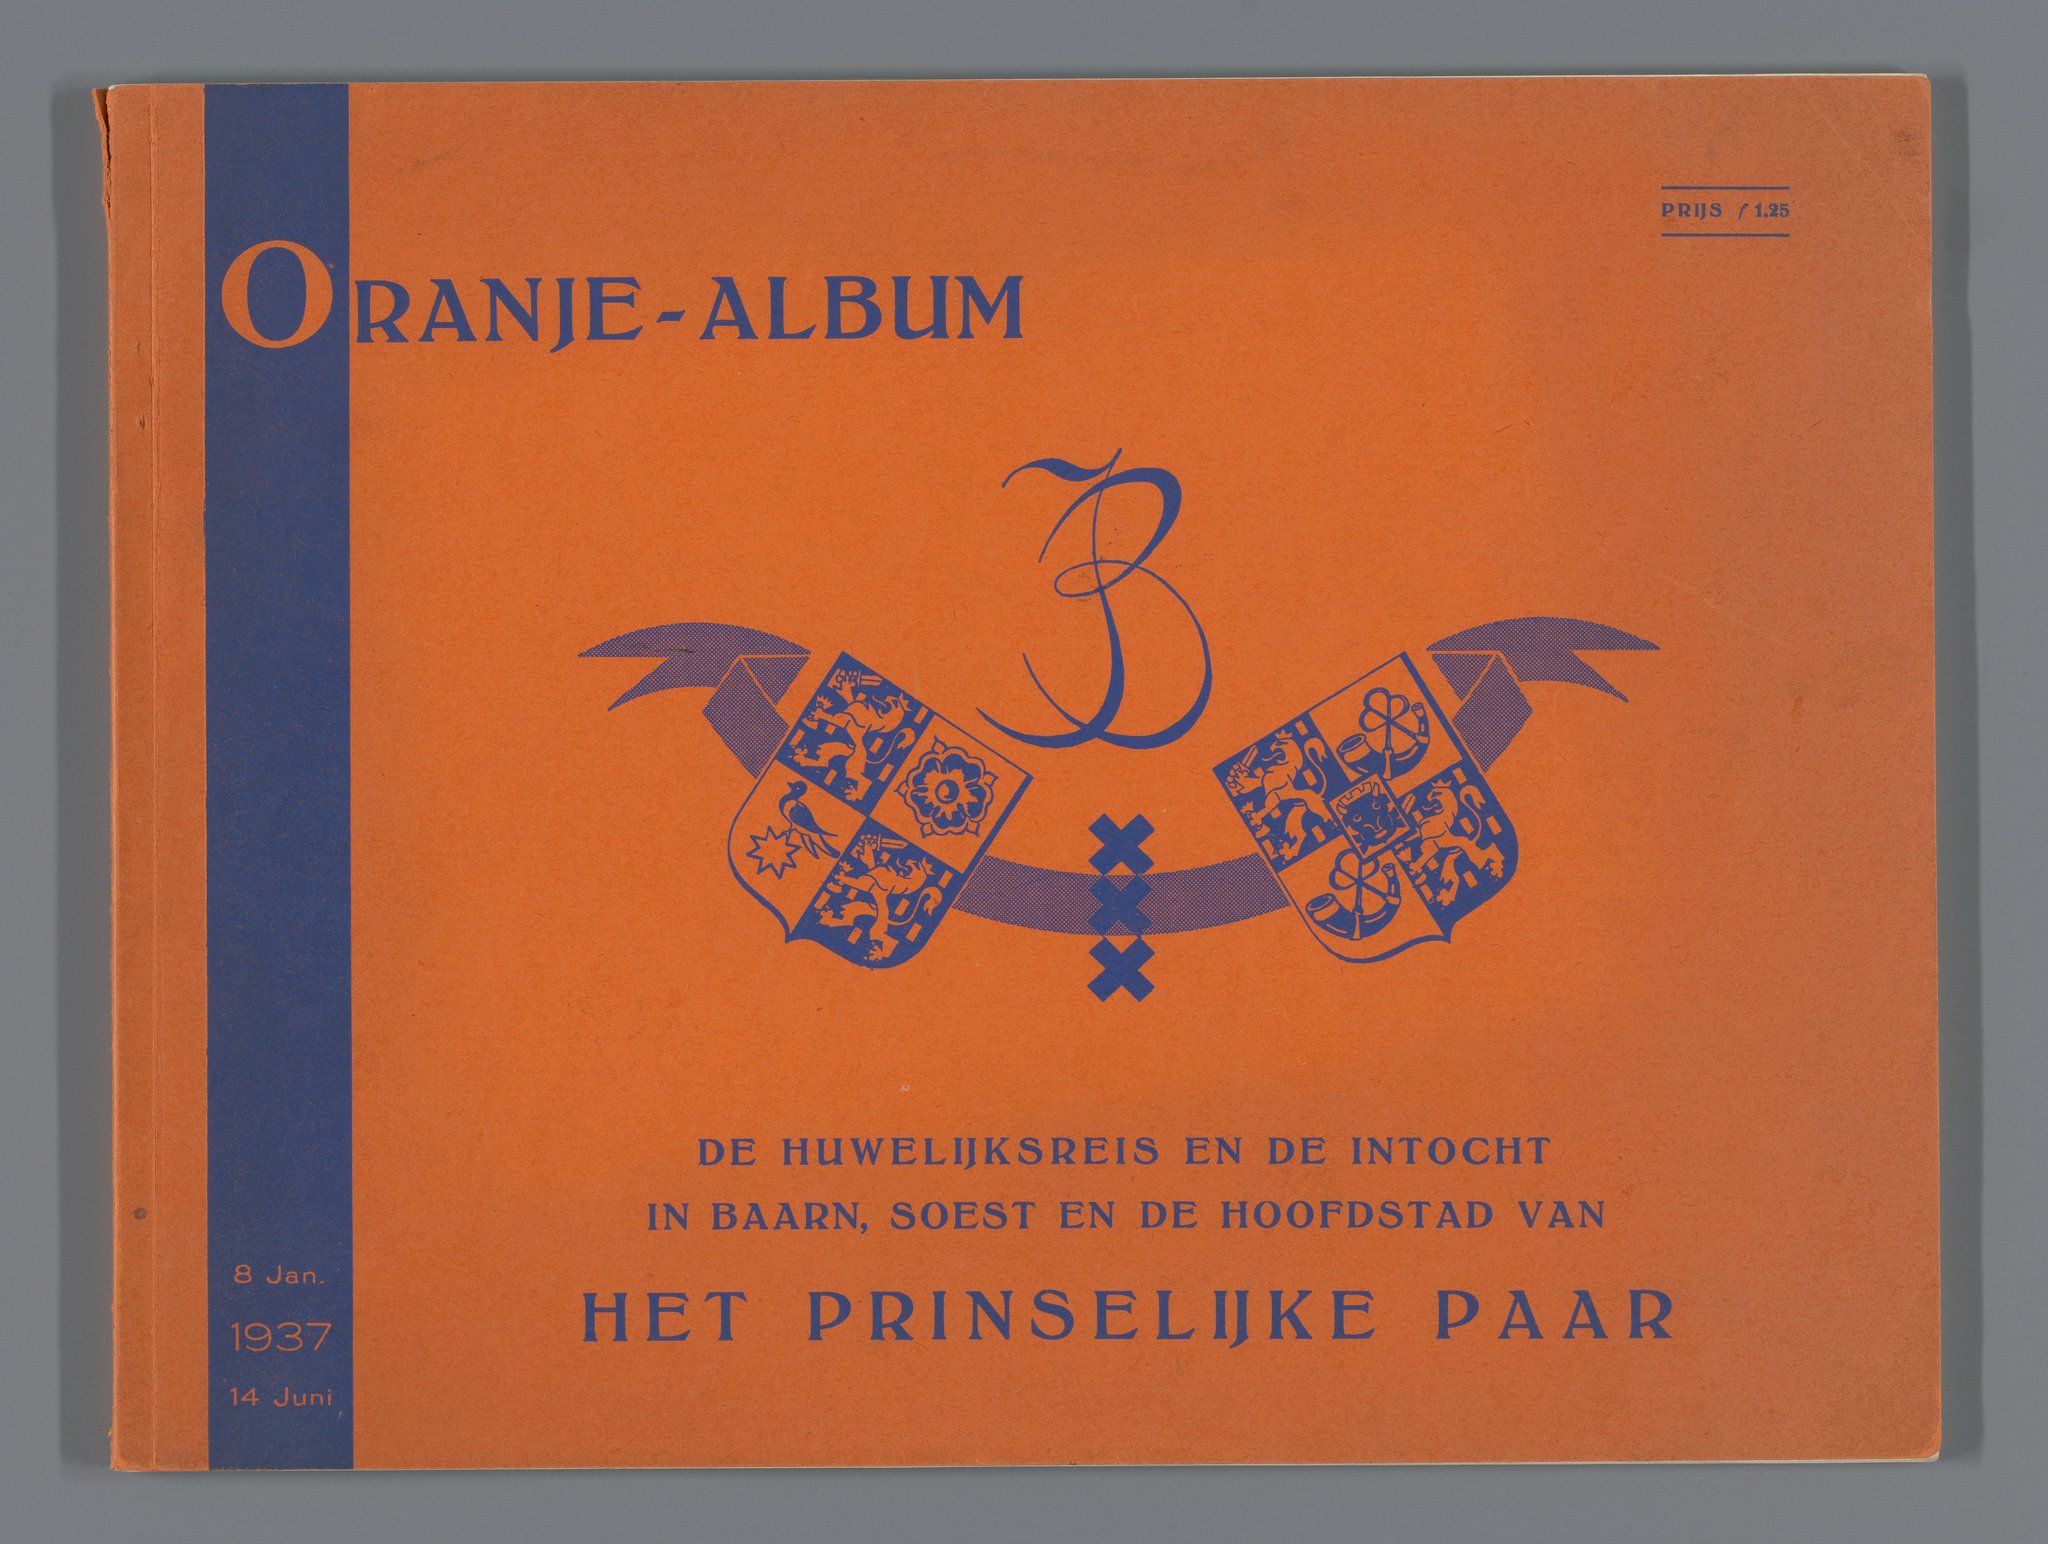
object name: album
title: Oranje-album; de huwelijksreis en de intocht te Baarn, Soest en de hoofdstad van het prinselijk paar 8 januari - 14 juni 1937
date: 1937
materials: cardboard, paper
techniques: brocade, printing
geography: amsterdam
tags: utrecht, bernhard (prins der nederlanden), the hague, juliana of the netherlands, amsterdam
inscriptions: date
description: 58 fotopagina's in oranje kartonnen omslag wit. Gedateerd; titelp.: 1937.